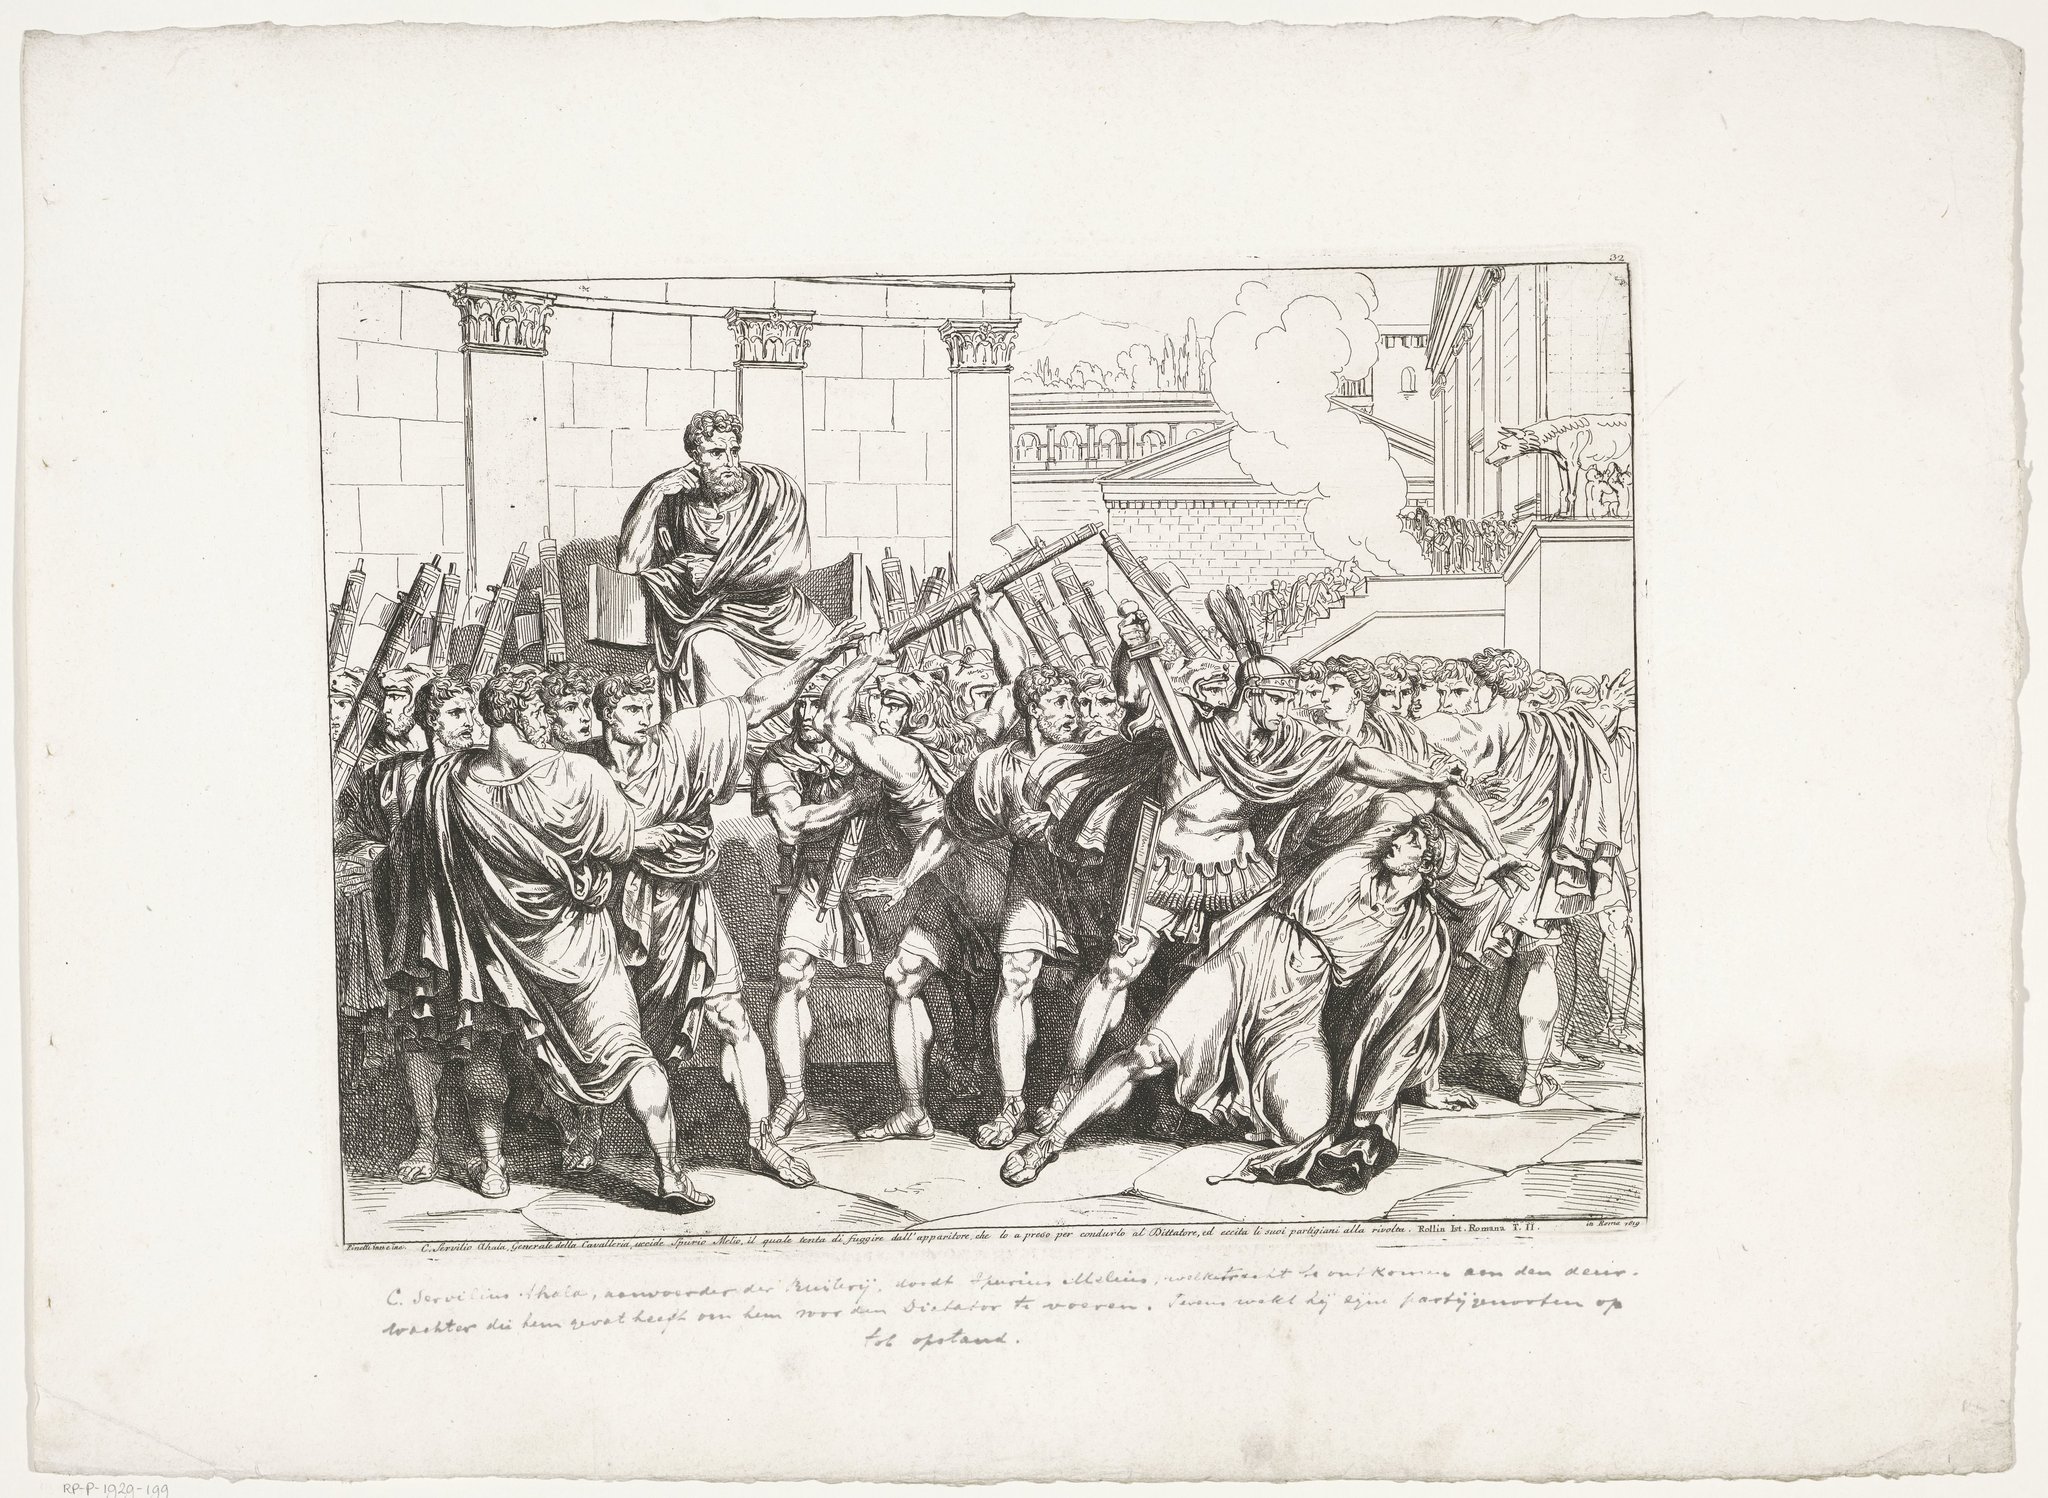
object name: print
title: Frontespizio della Istoria Romana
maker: bartolomeo pinelli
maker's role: draughtsman, print maker, sculptor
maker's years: 1781-1835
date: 1819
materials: paper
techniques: etching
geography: rome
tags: hacking and thrusting weapons: dagger, murder, the soldier; the soldier's life, violent death by dagger, knife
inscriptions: collector's mark: Lugt 2228, inscription: ‘C. Servilius Hala, aanvoerder der Ruiterij, doodt Spurius Melius, welke tracht te ontkomen aan den deur- / wachter die hem gevat heeft om hem voor den Dictator te voeren. Tevens wekt hij zijne partijgenooten op / tot opstand.’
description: Gaius Servilius Ahala doodt Spurius Maelius door hem te steken met een dolk. Een menigte Romeinen kijkt toe.